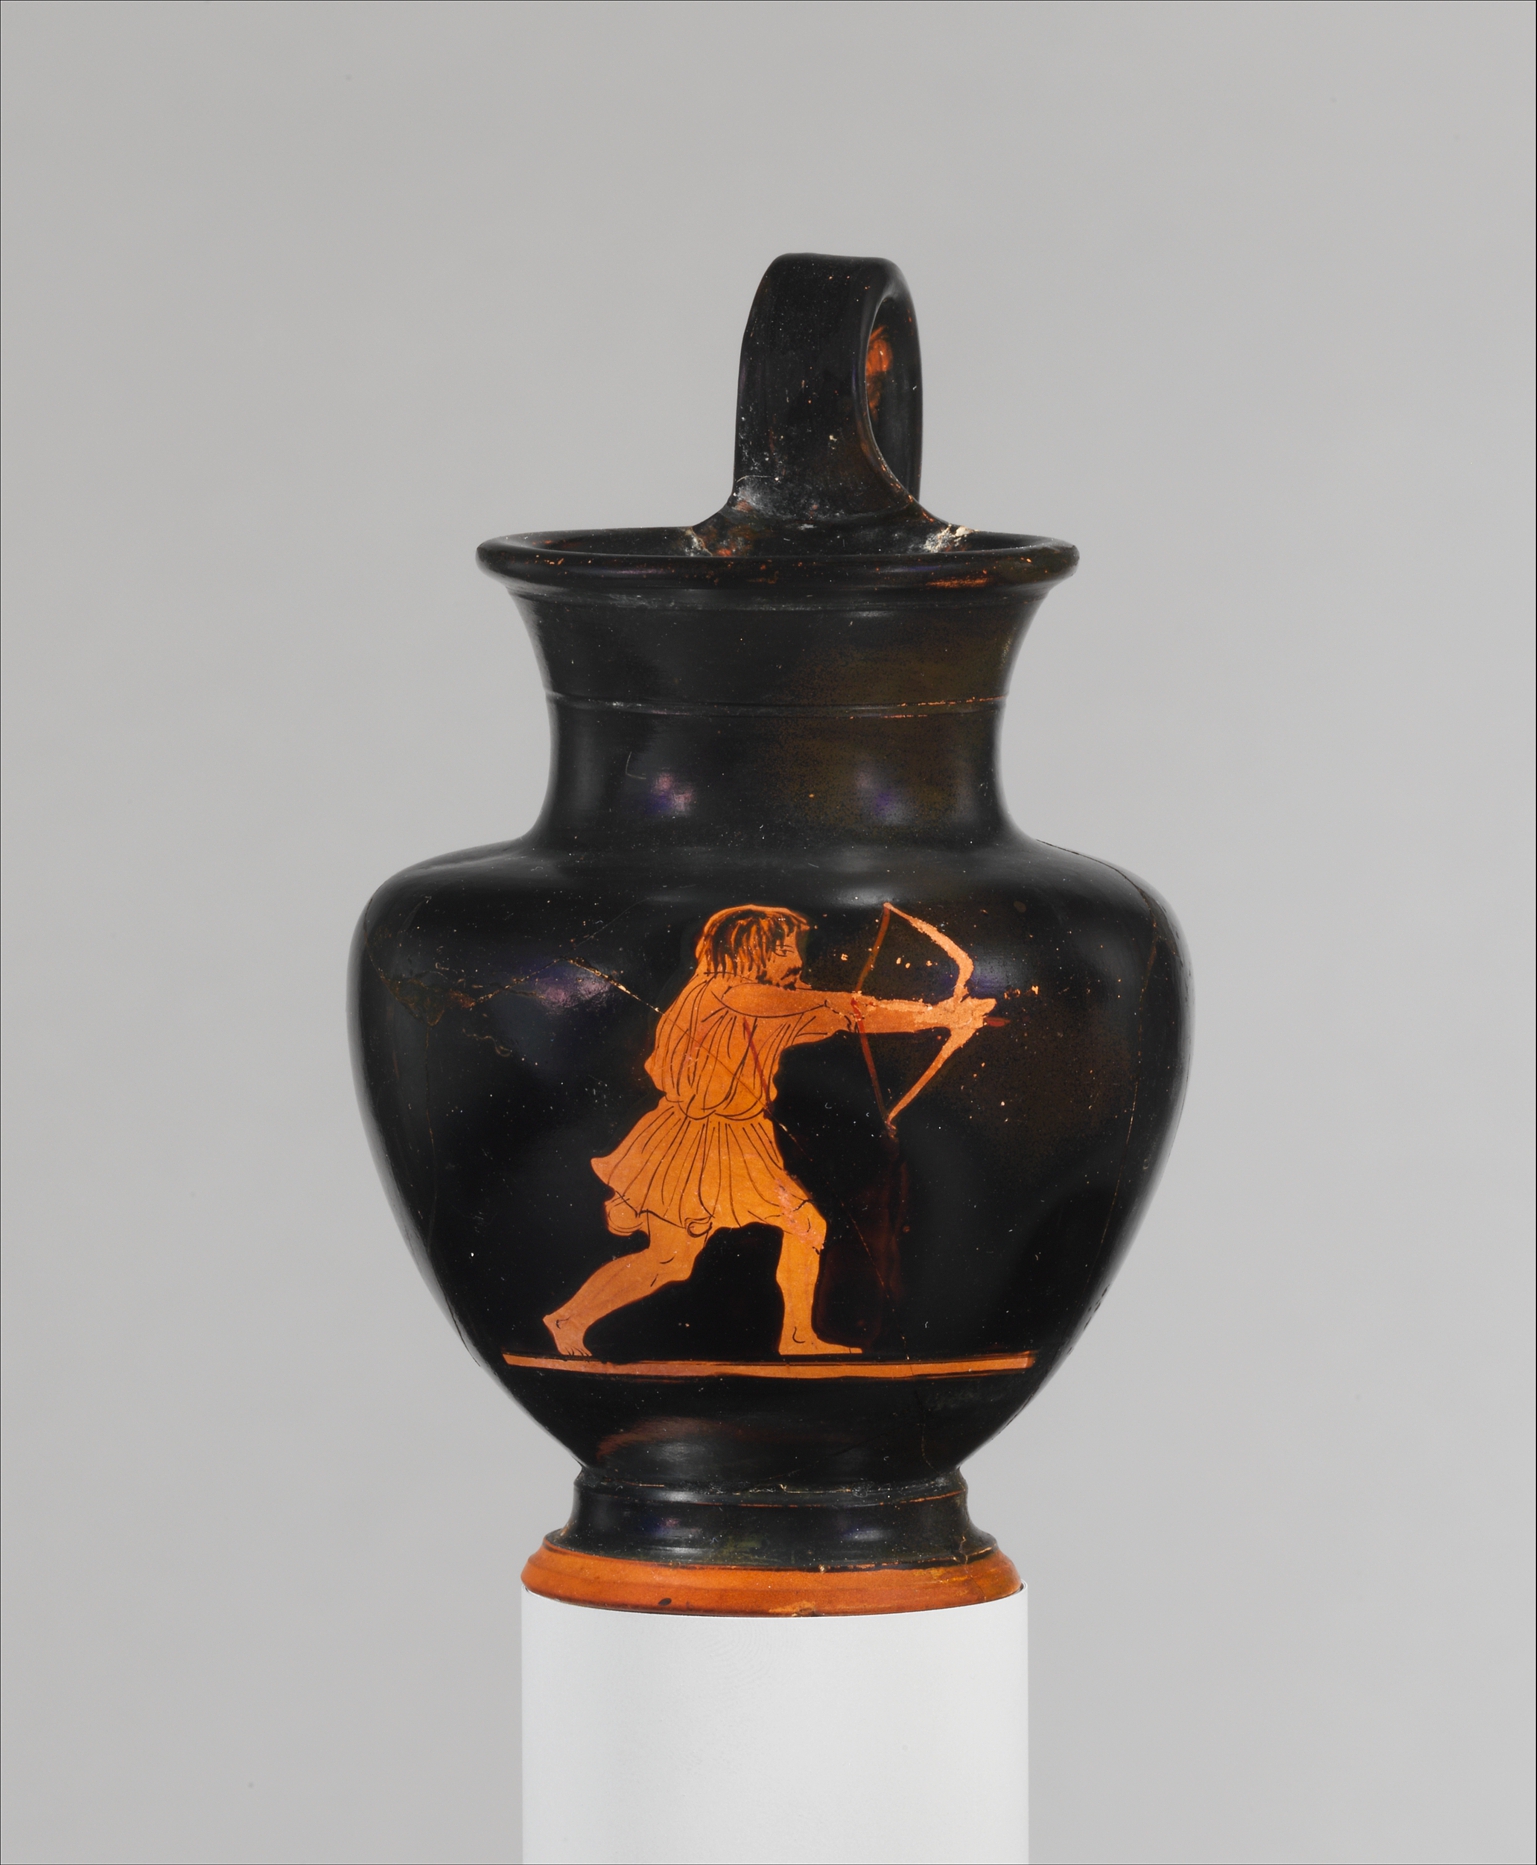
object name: oinochoe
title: Terracotta oinochoe (jug)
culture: greek, attic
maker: disney painter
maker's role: artist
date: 430-420 BCE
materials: terracotta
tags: bow and arrow,men,archery